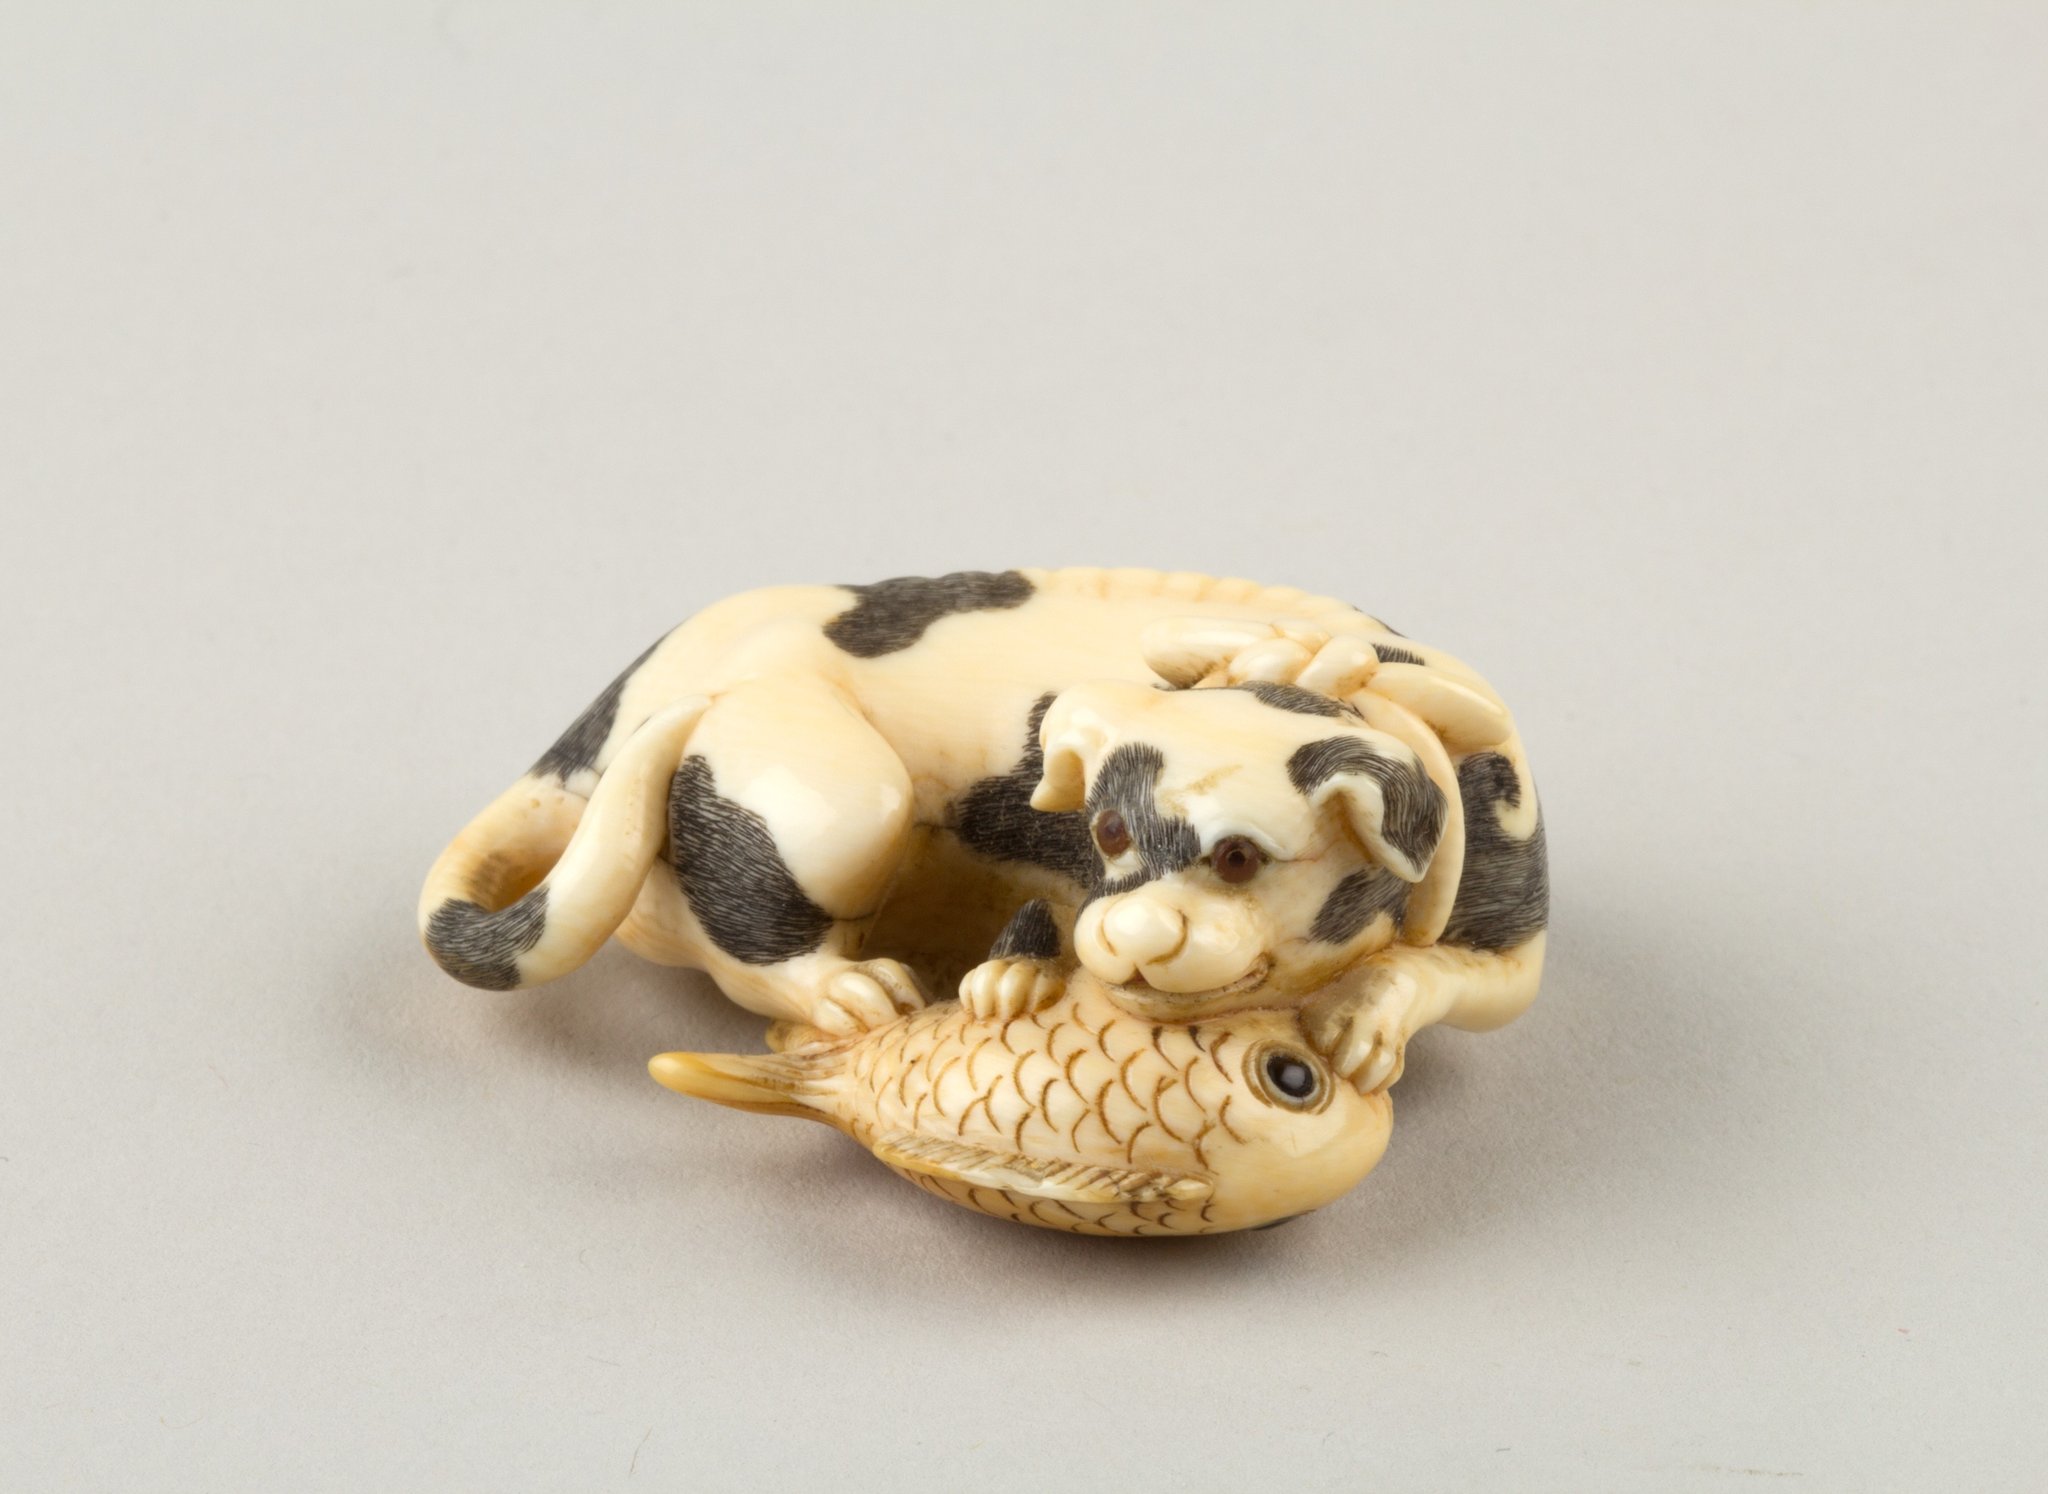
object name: netsuke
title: Netsuke of a Dog and a Fish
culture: japanese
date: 1867-1933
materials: horn, ivory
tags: dogs,fish